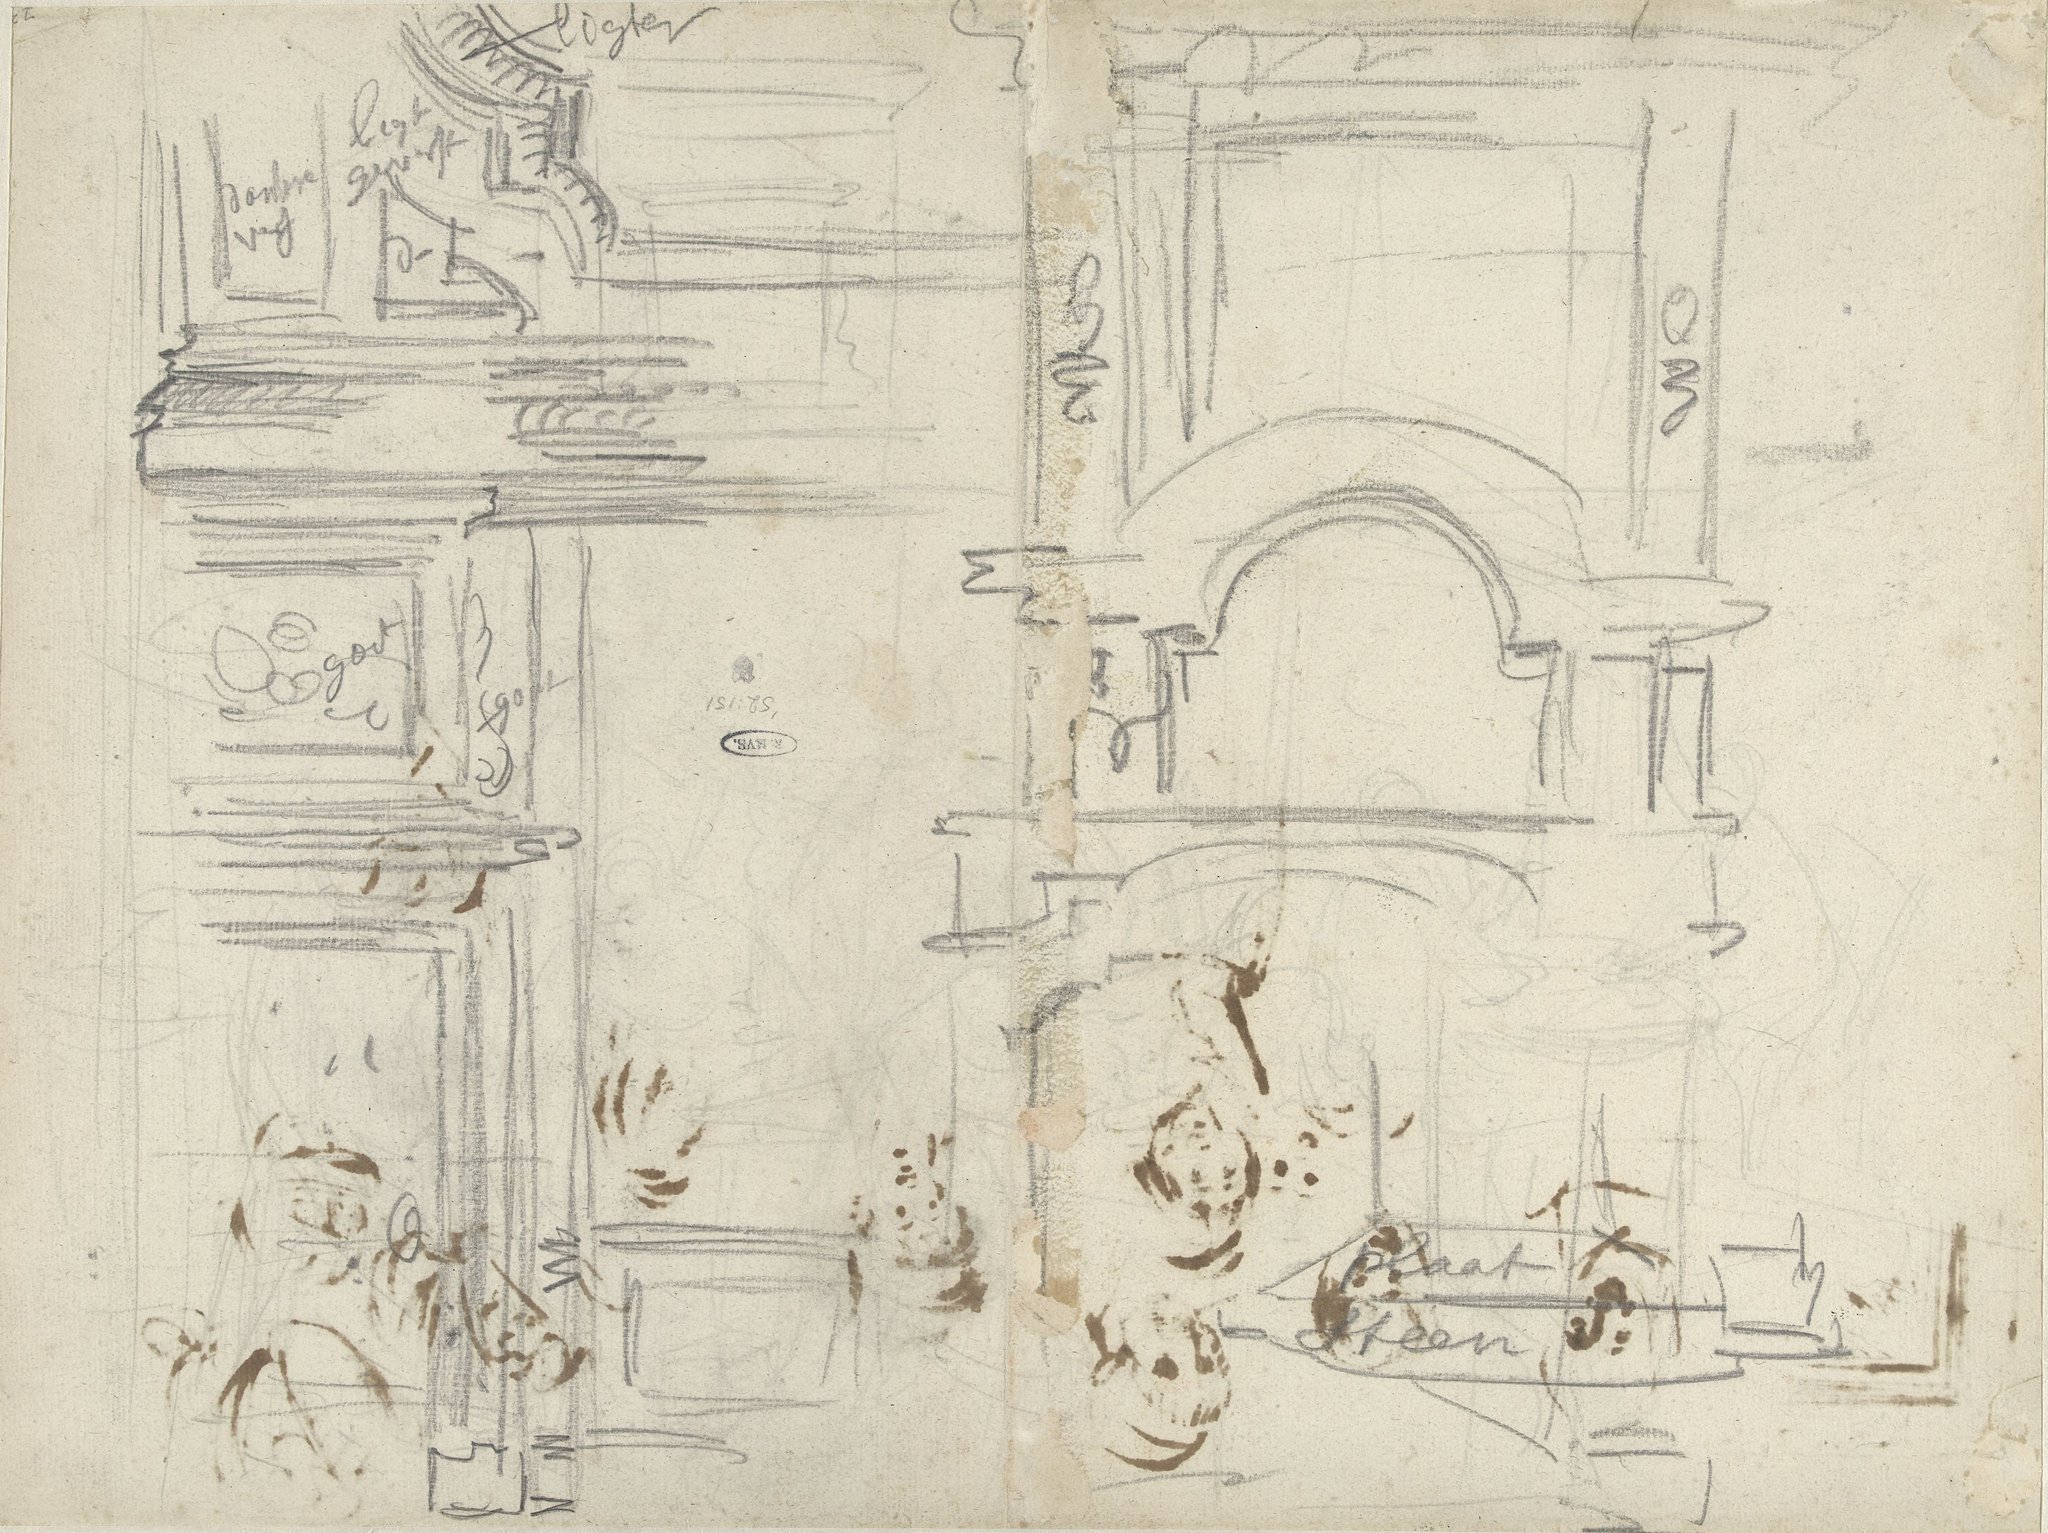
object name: drawing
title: Studies van betimmeringen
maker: simon andreas krausz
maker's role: draughtsman, print maker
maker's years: 1760-1825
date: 1770-1825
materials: paper, pencil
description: Schetsblad met studies van betimmeringen.